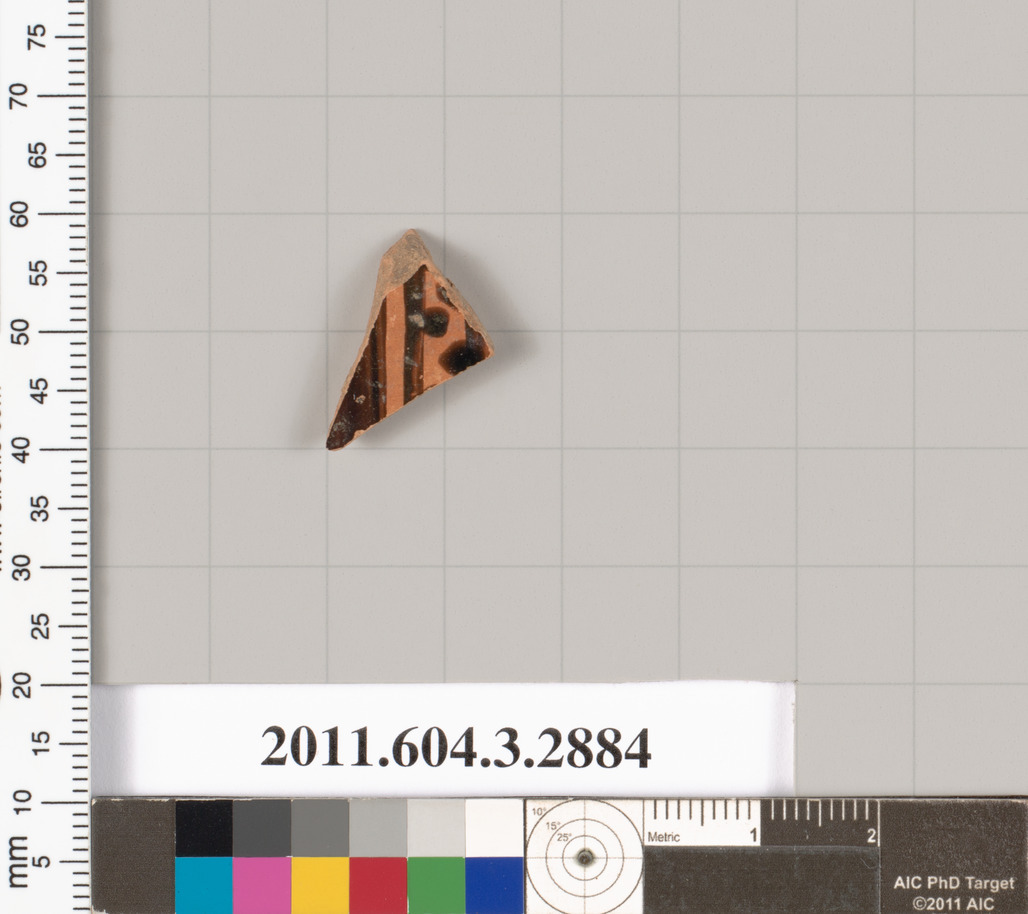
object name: undetermined closed shape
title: Terracotta fragment of a closed shape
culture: greek, attic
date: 534-468 BCE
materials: terracotta